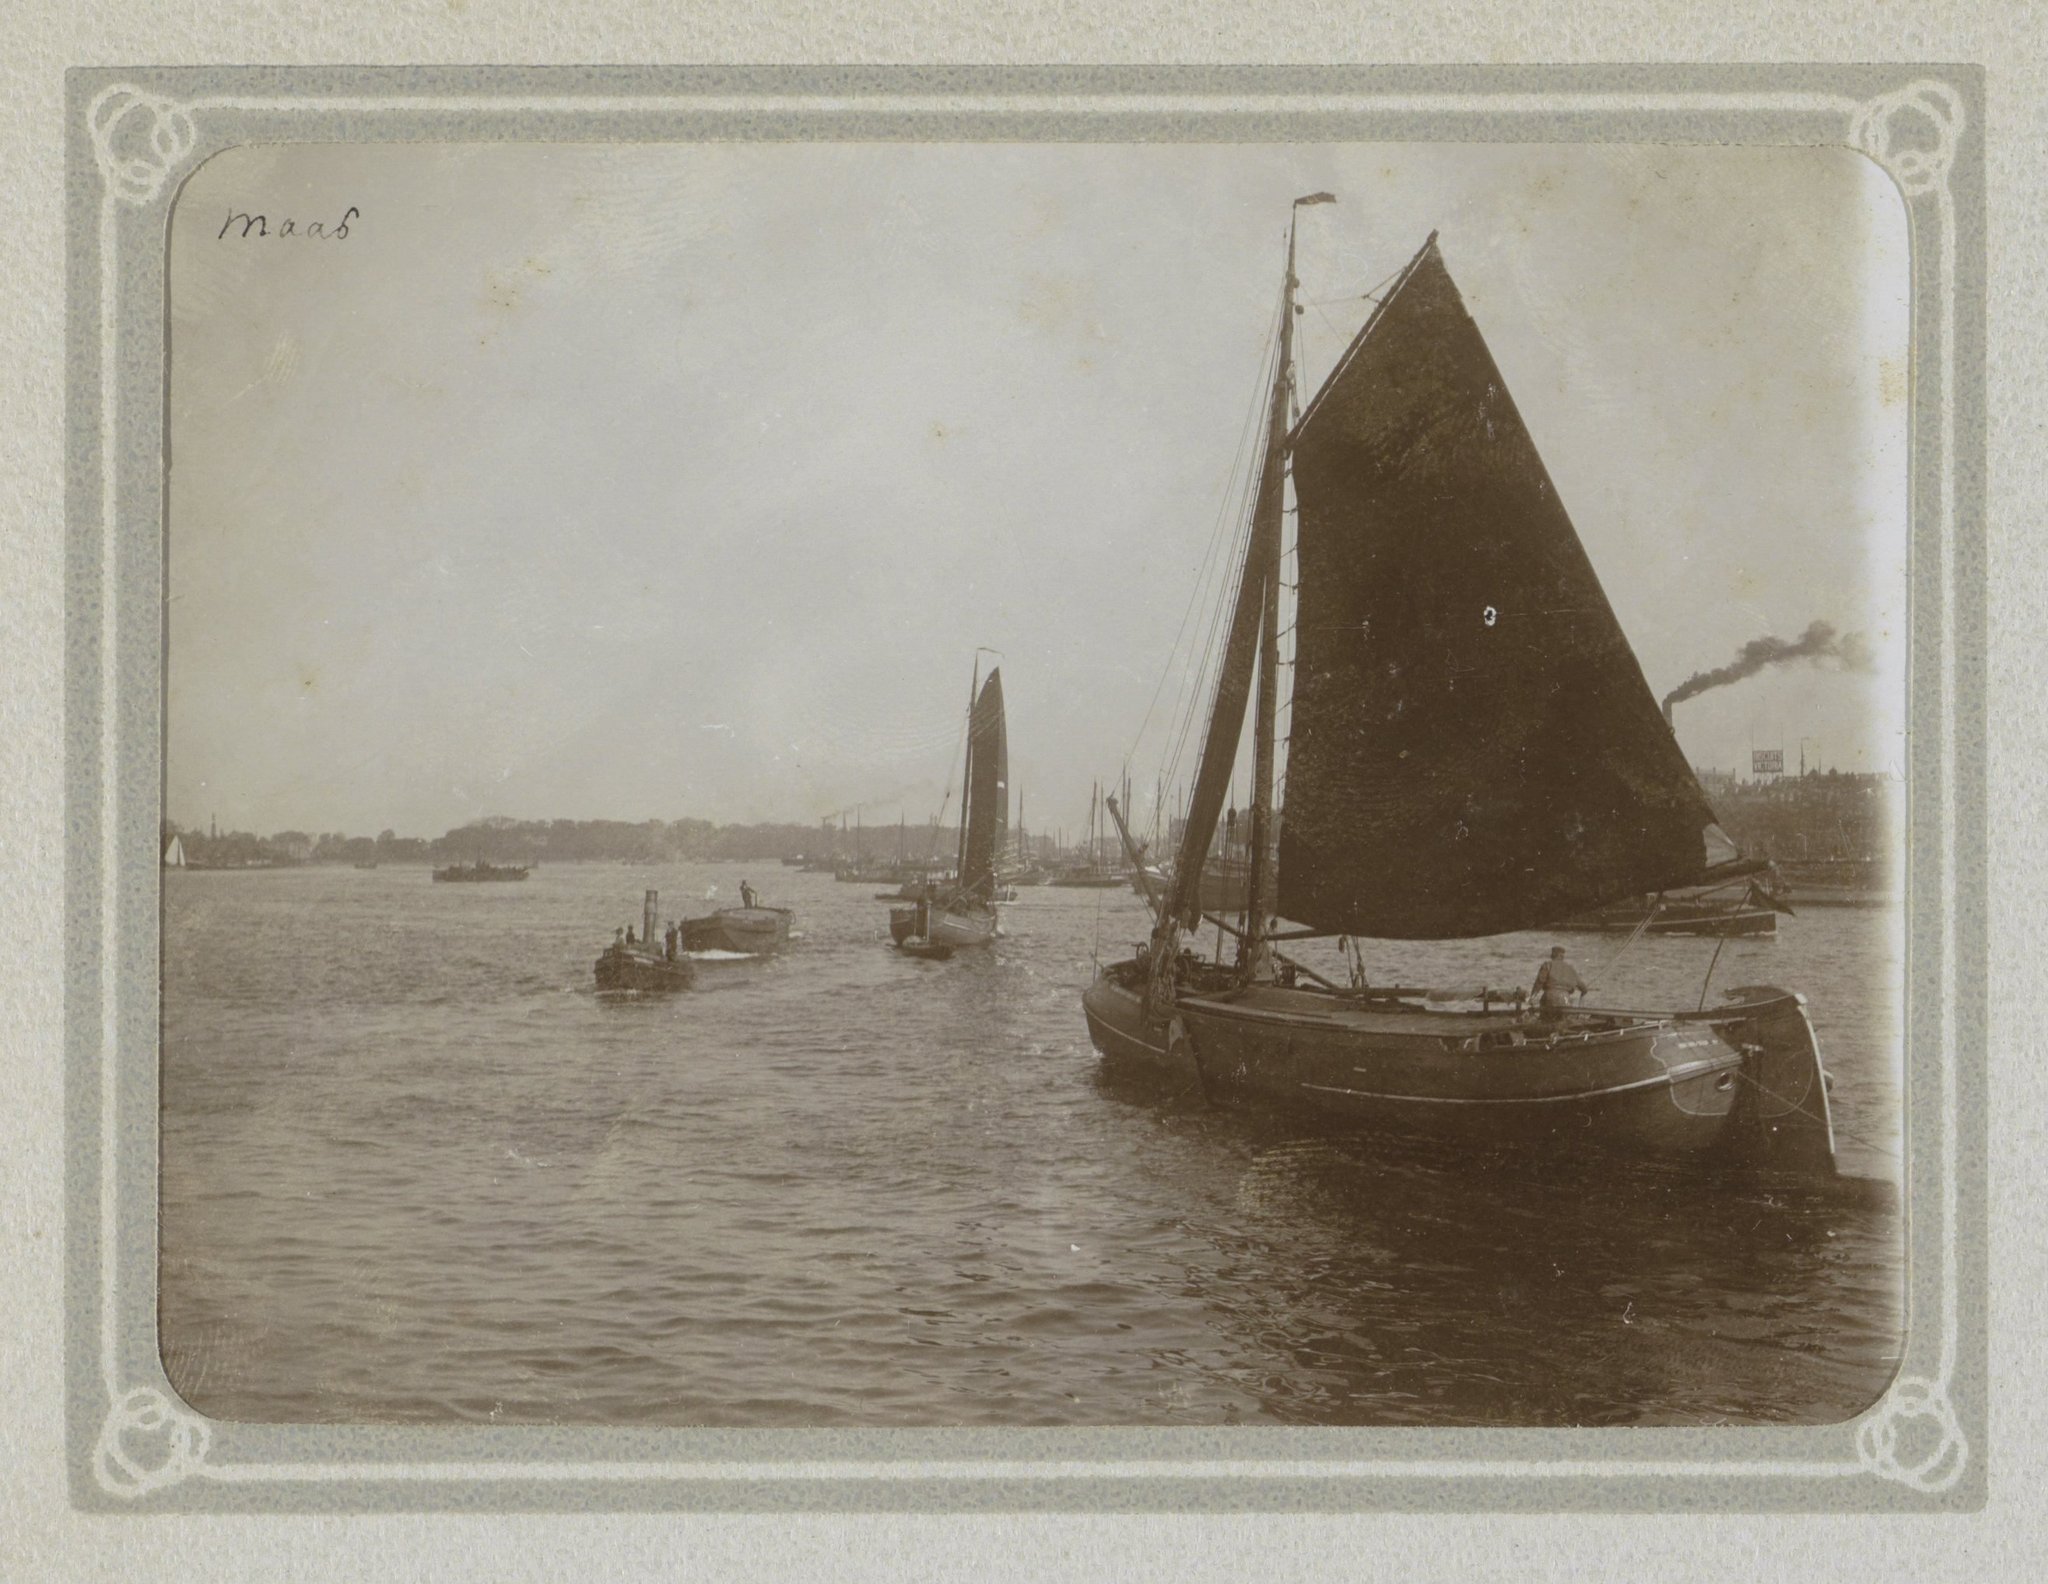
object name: photograph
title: Zeilschepen op de Maas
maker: folkert idzes de jong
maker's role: architect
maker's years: 1877-1929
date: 1905-1907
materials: photographic support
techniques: collodion silver print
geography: meuse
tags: sailing-ship, sailing-boat, river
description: Onderdeel van Topografisch album van Nederlandse dorpen en steden 1905.